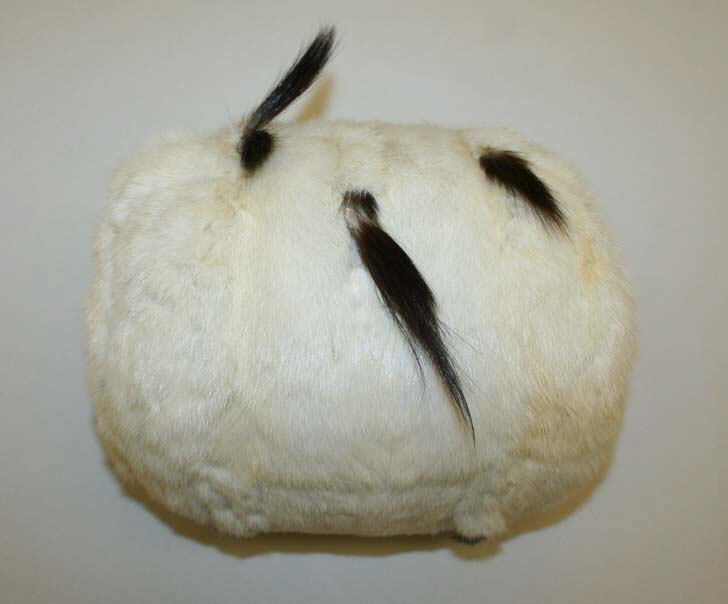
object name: muff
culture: american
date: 1895-1899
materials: fur